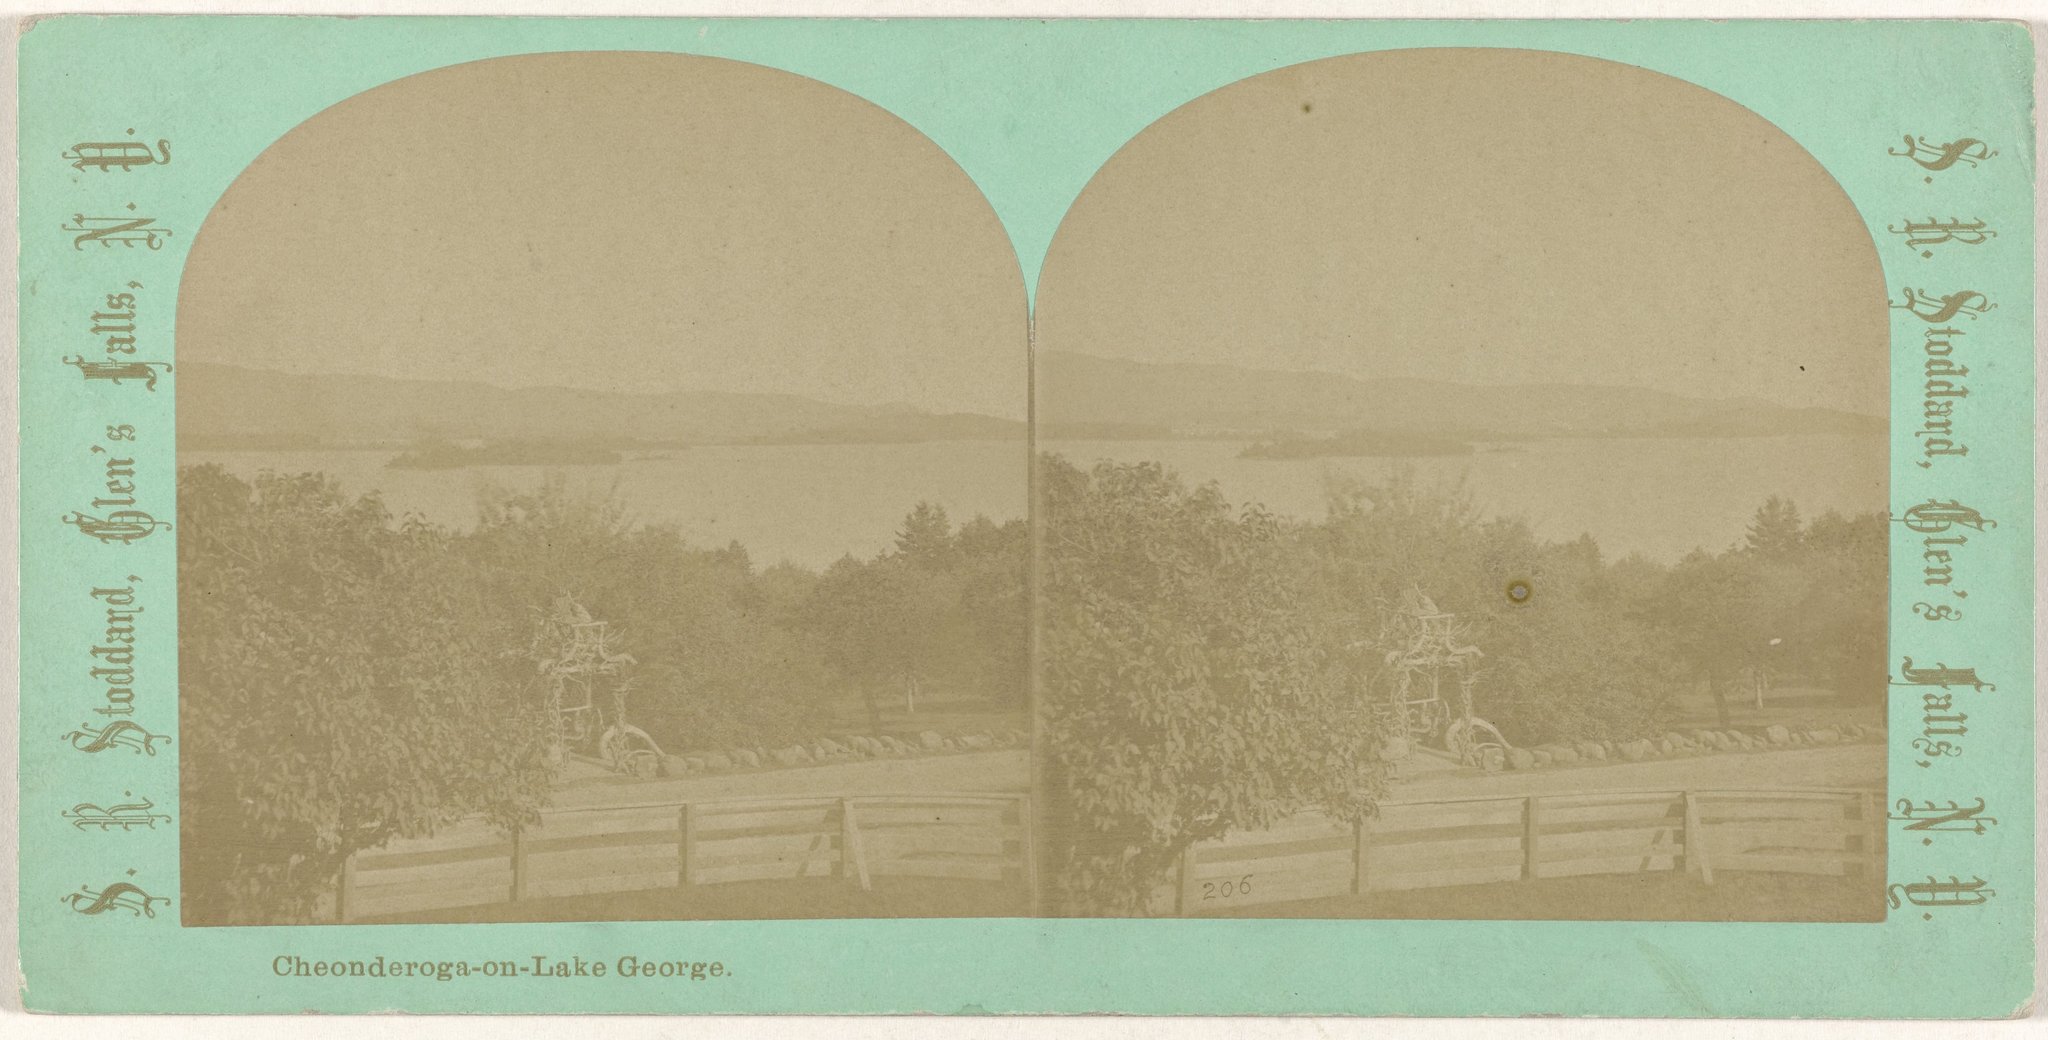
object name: stereograph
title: Cheonderoga-on-Lake George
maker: seneca ray stoddard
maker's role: fotograaf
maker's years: 1843-1917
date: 1868-1873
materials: cardboard, paper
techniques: albumen print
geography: lake george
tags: lake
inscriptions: number: ‘206’